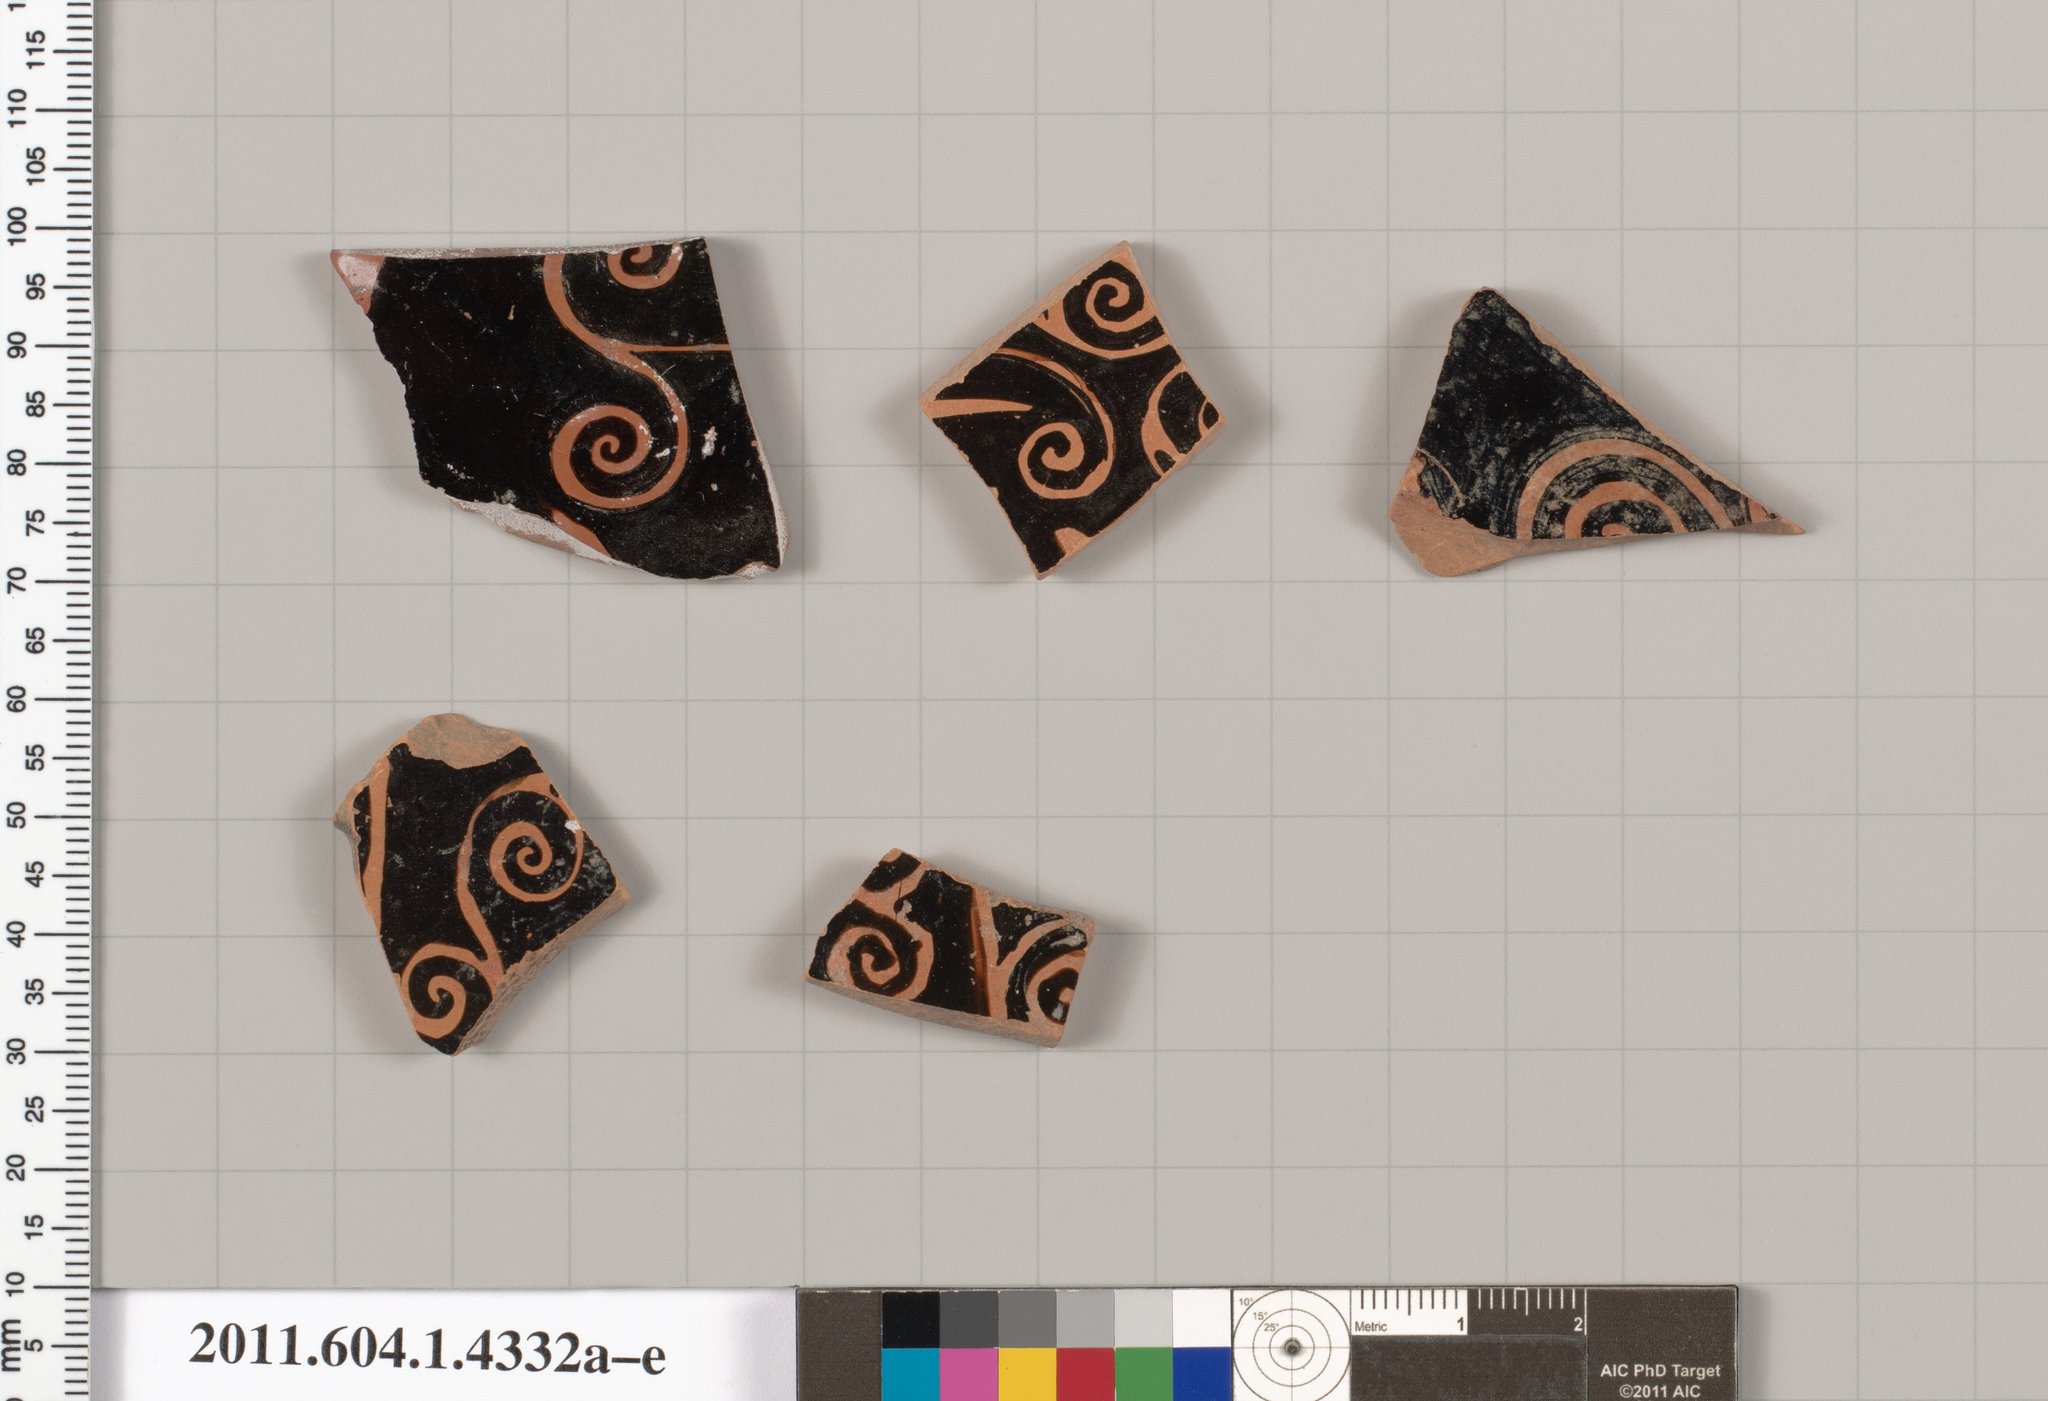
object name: kylix fragment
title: Terracotta fragments of kylikes (drinking cups)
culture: greek, attic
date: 500-451 BCE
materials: terracotta